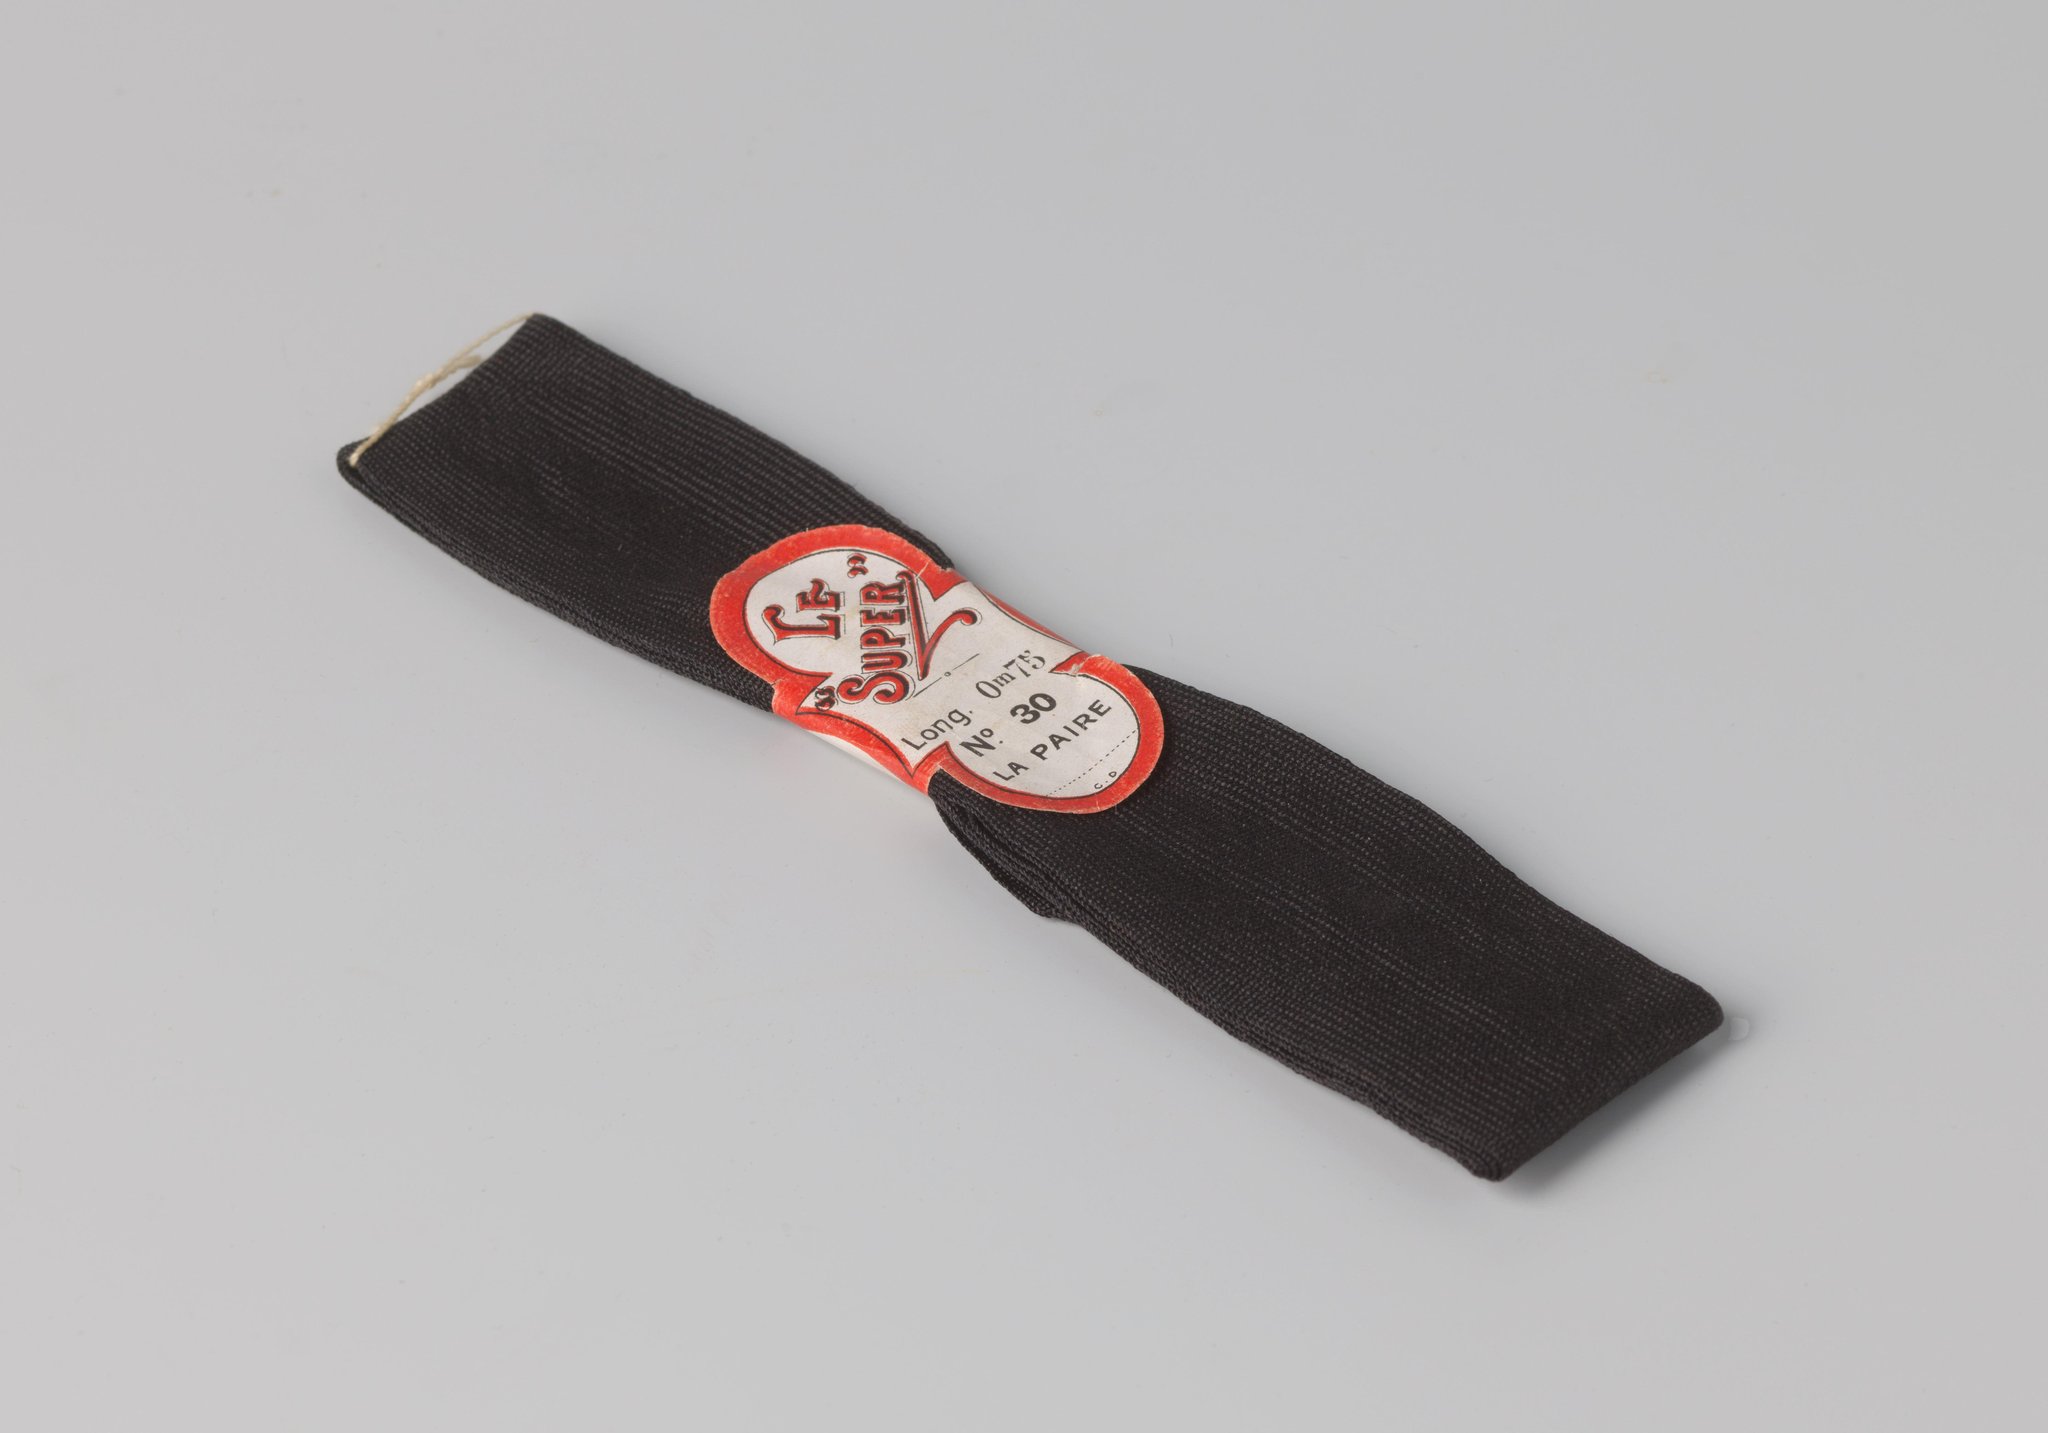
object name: clothing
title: Paar (?) veters van grijsblauwe polyester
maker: Anonymous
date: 1945-1965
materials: metal, plastic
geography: western europe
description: Paar (?) veters van grijsblauwe polyester met licht ingeweven argile ruit, ongebruikt, in orginele verpakking.